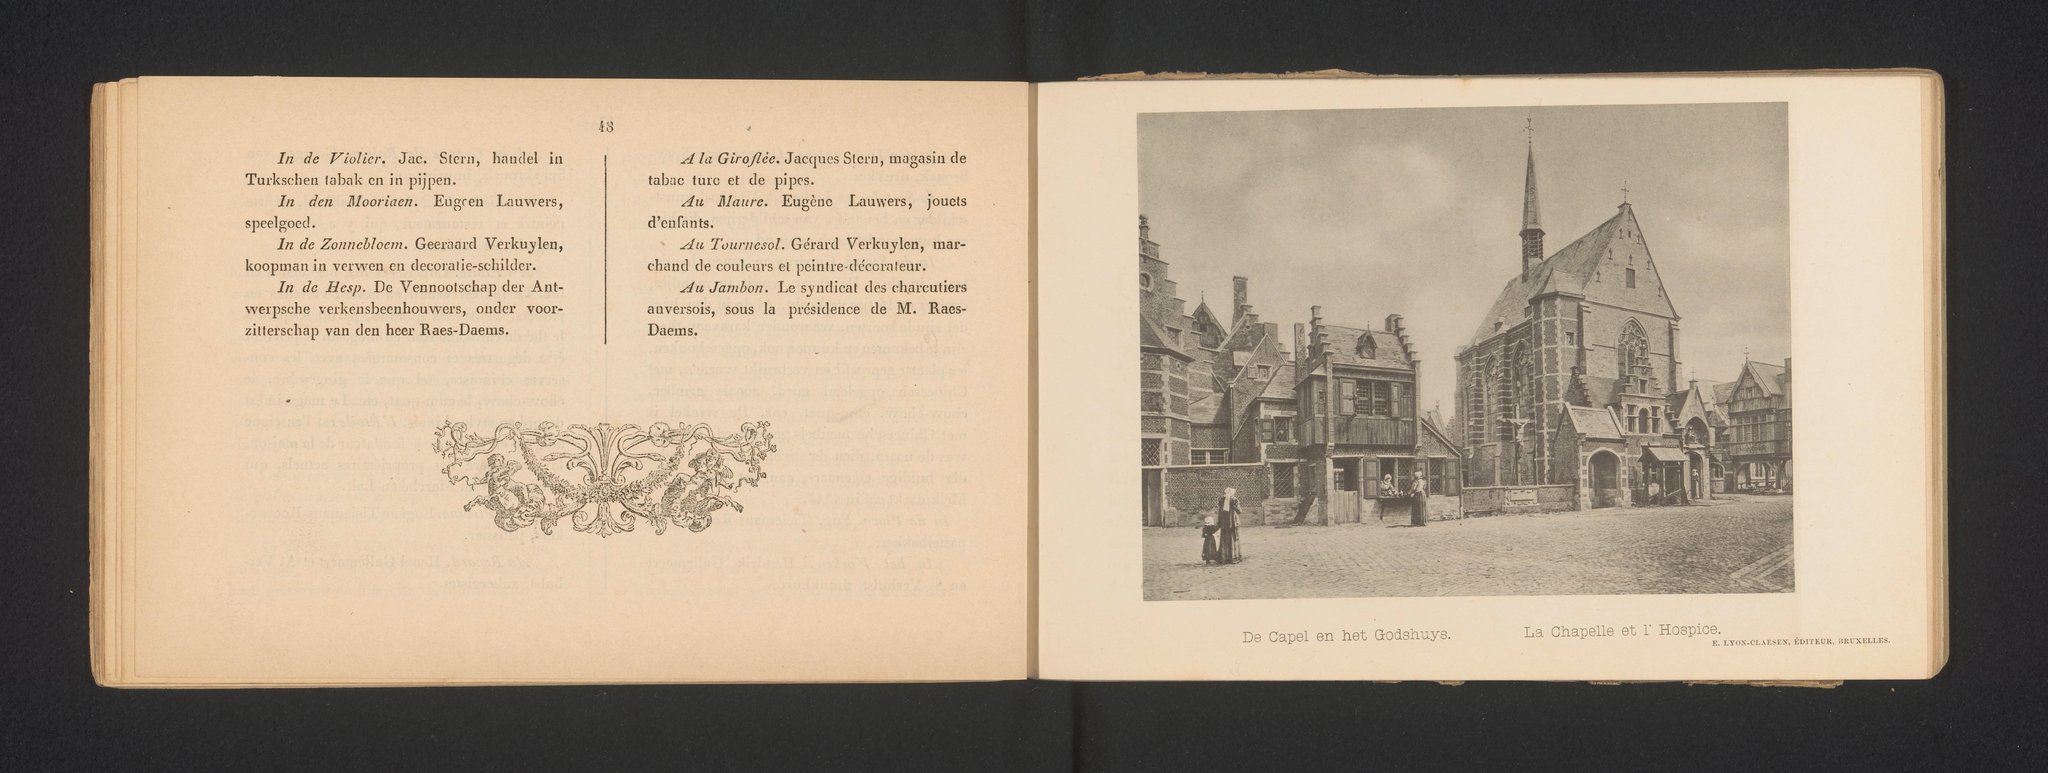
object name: photomechanical print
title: Gezicht op een kapel en kerk in Antwerpen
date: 1889-1894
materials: paper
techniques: photograph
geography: brussels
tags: parts of church exterior and annexes: chapel, church (exterior), antwerp